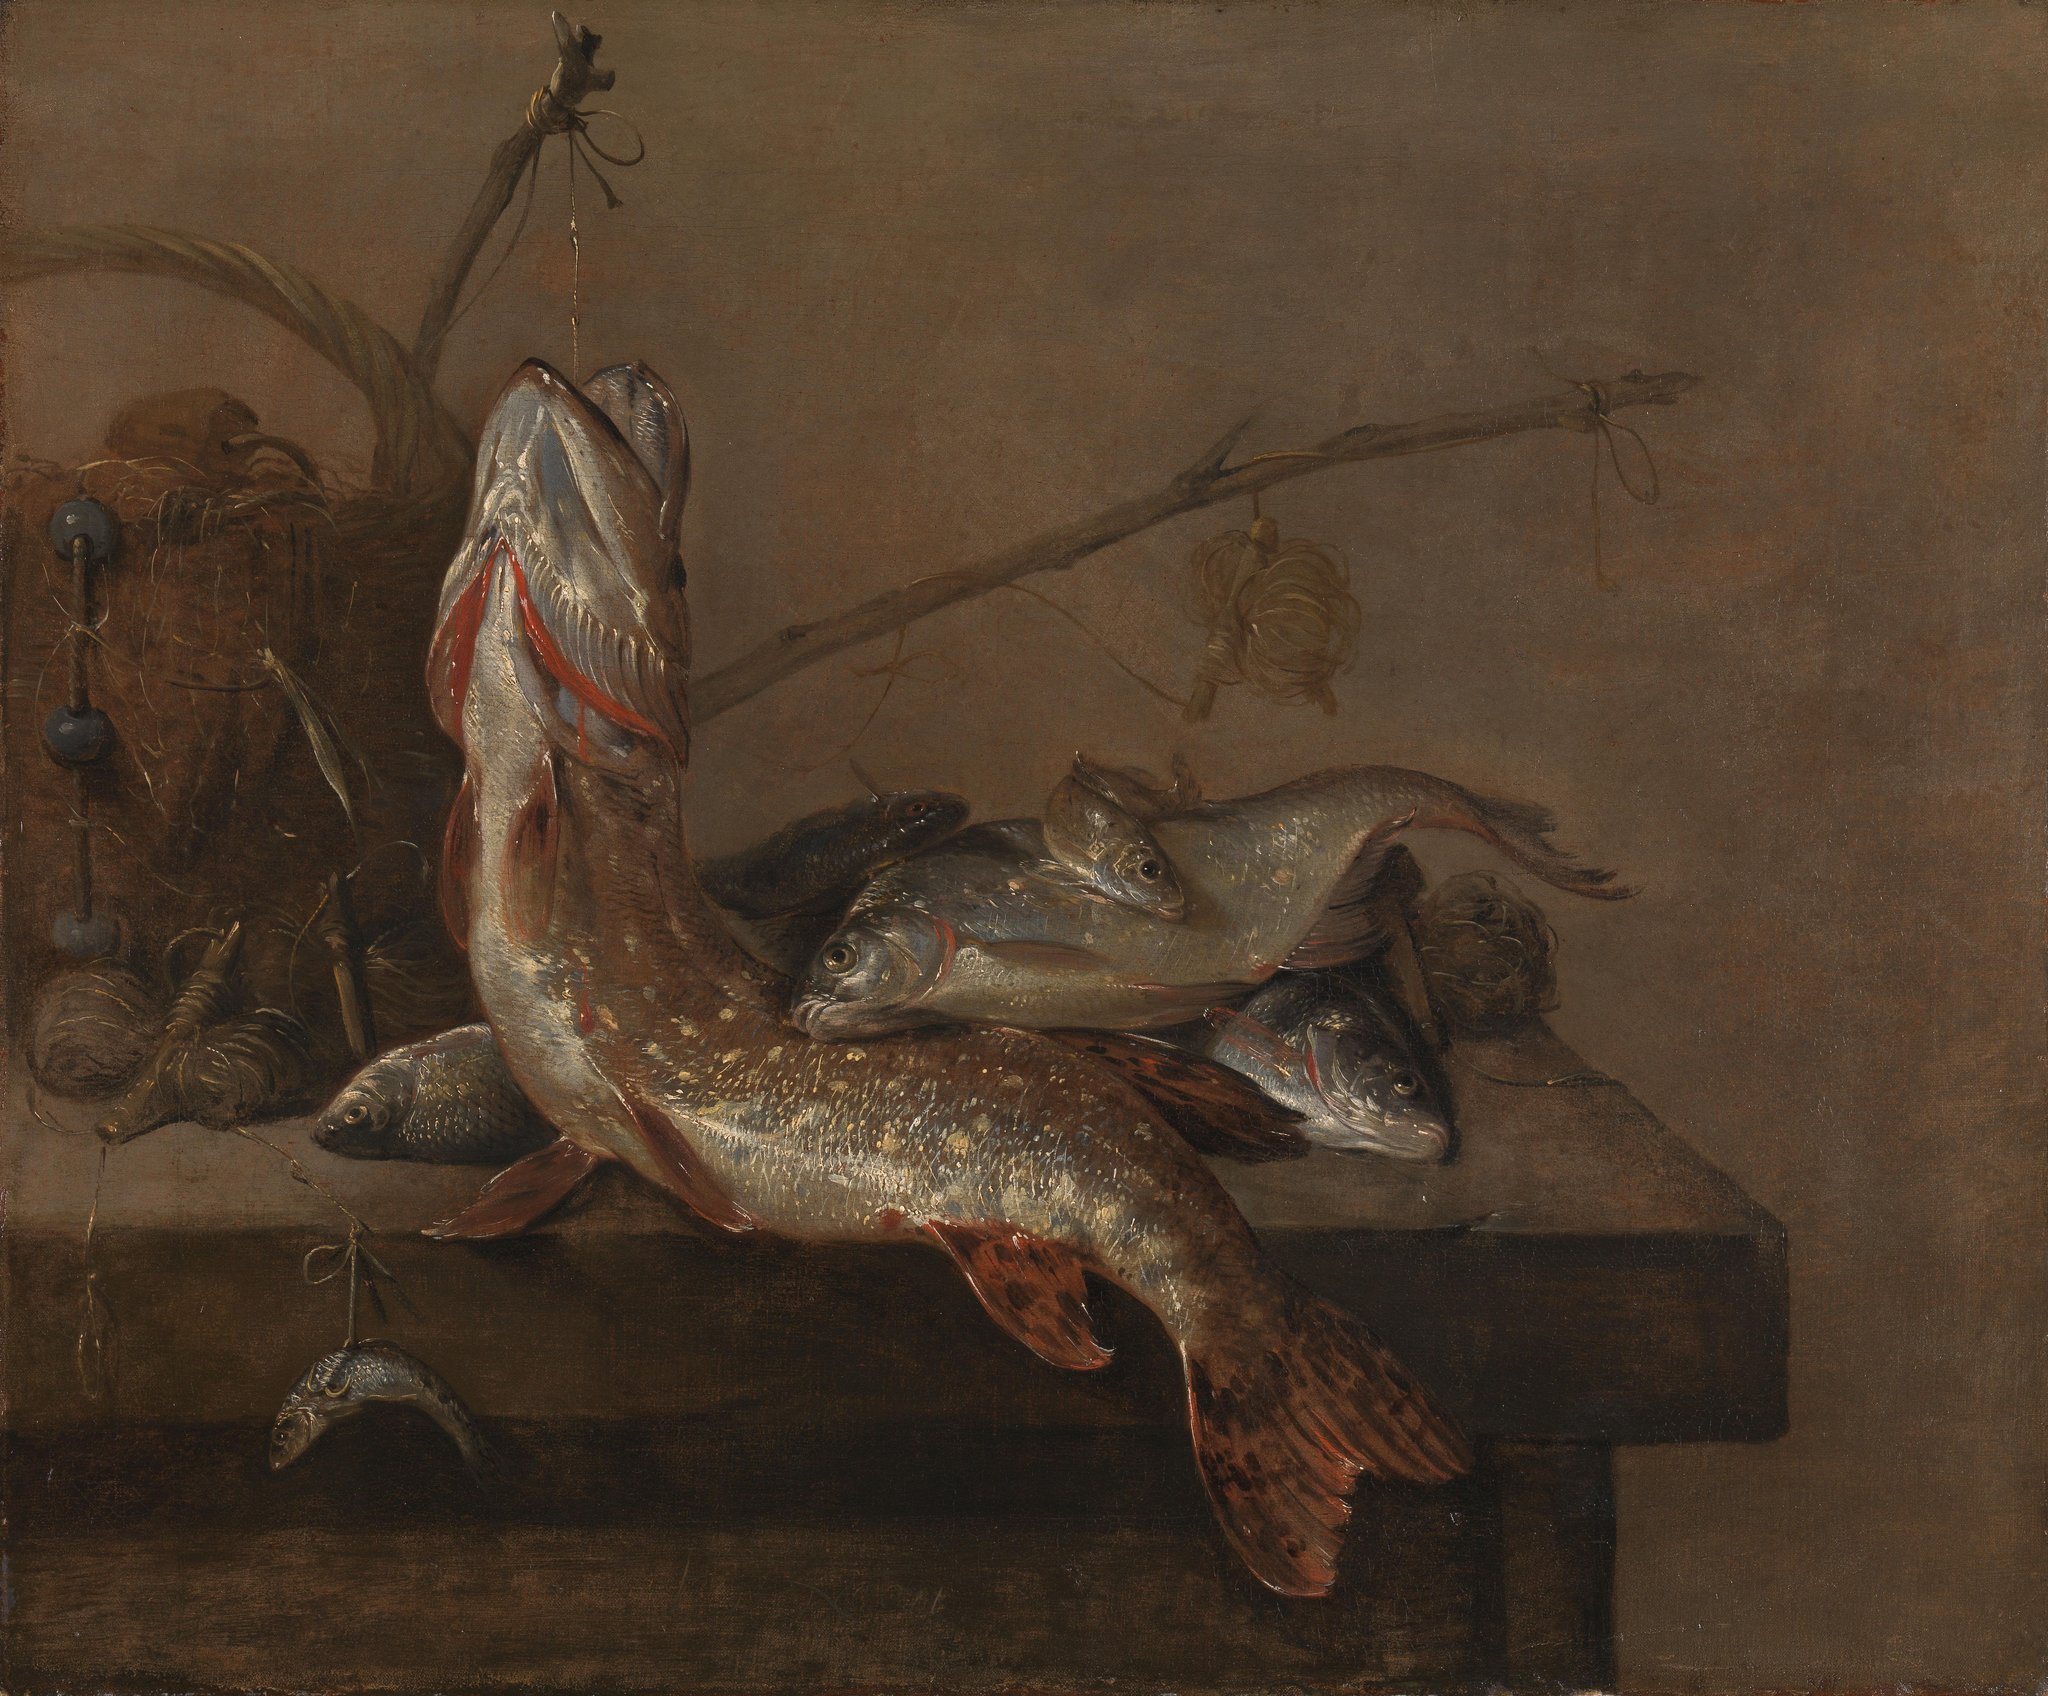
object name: painting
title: Still life with fish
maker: pieter van noort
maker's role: painter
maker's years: 1622-1672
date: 1648-1672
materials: canvas, oil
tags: fishes, fish; still life of fishes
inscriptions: signature: ‘P. v. Noort’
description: Visstilleven. Stilleven met verschillende soorten vis (vorens, kabeljauw?) uitgestald op een tafel. Links een mand met klossen lijn en een vis als aas aan een lijn. Op de achtergrond een stok met lijn als hengel.